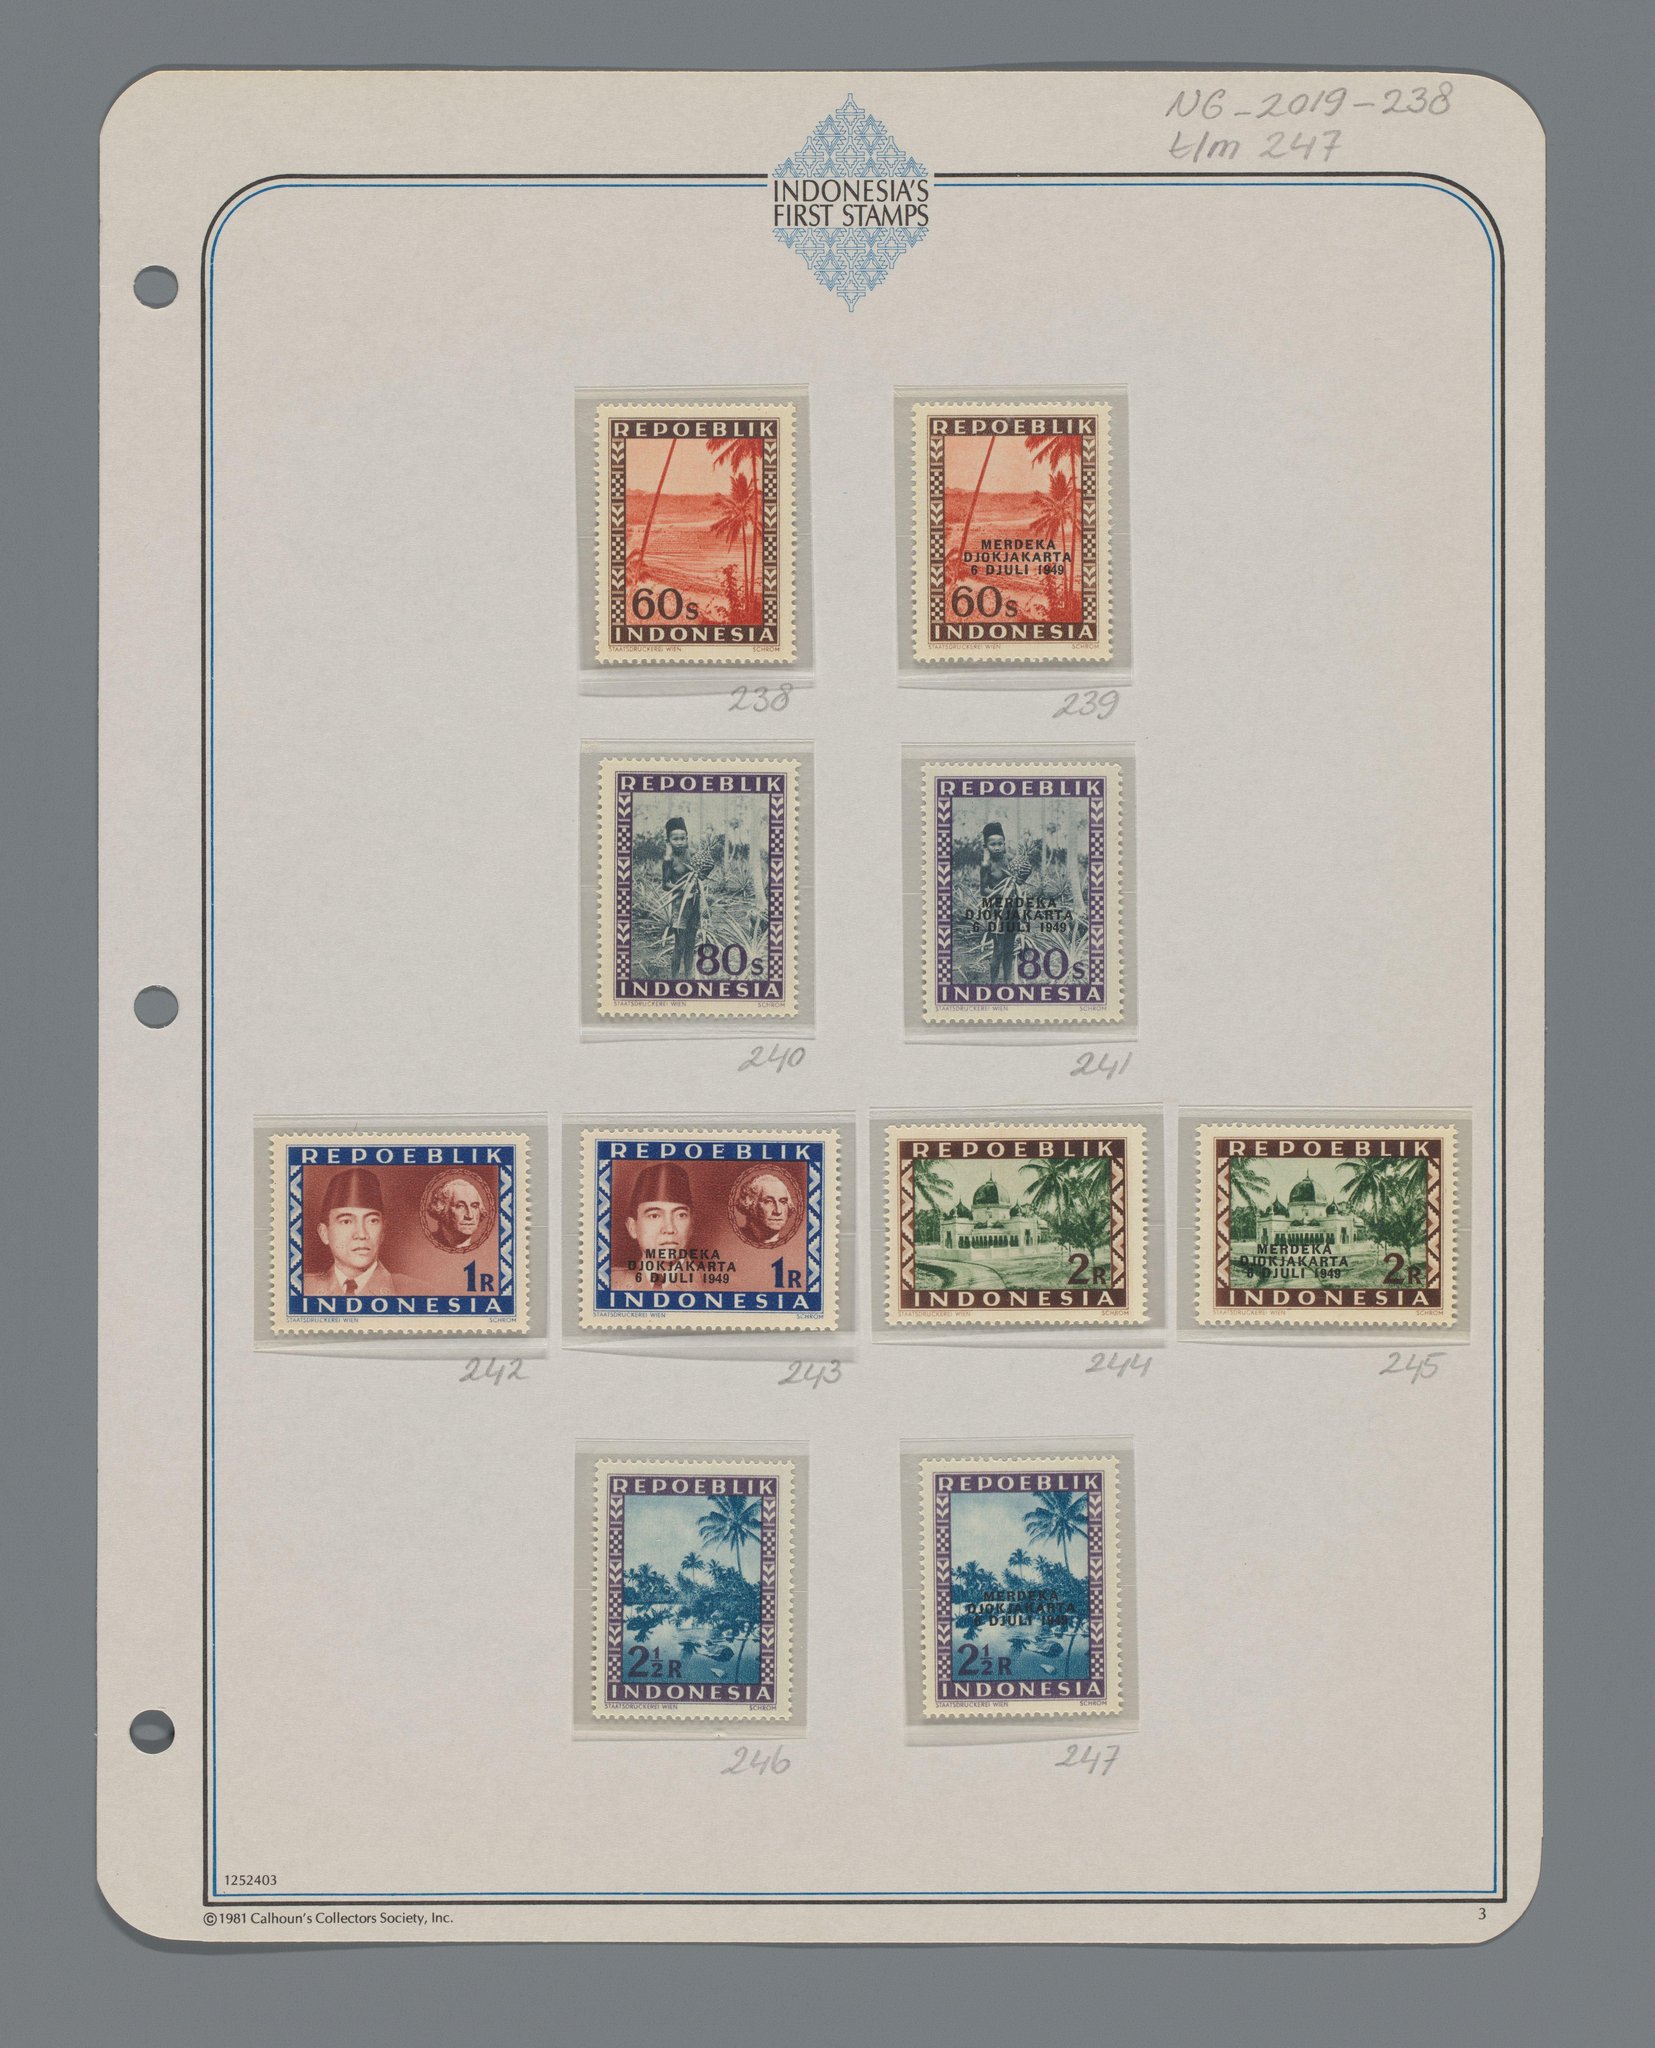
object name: postage stamp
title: Postzegel Republik Indonesia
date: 1949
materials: paper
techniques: photoaquatint, engraving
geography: philadelphia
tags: indonesia